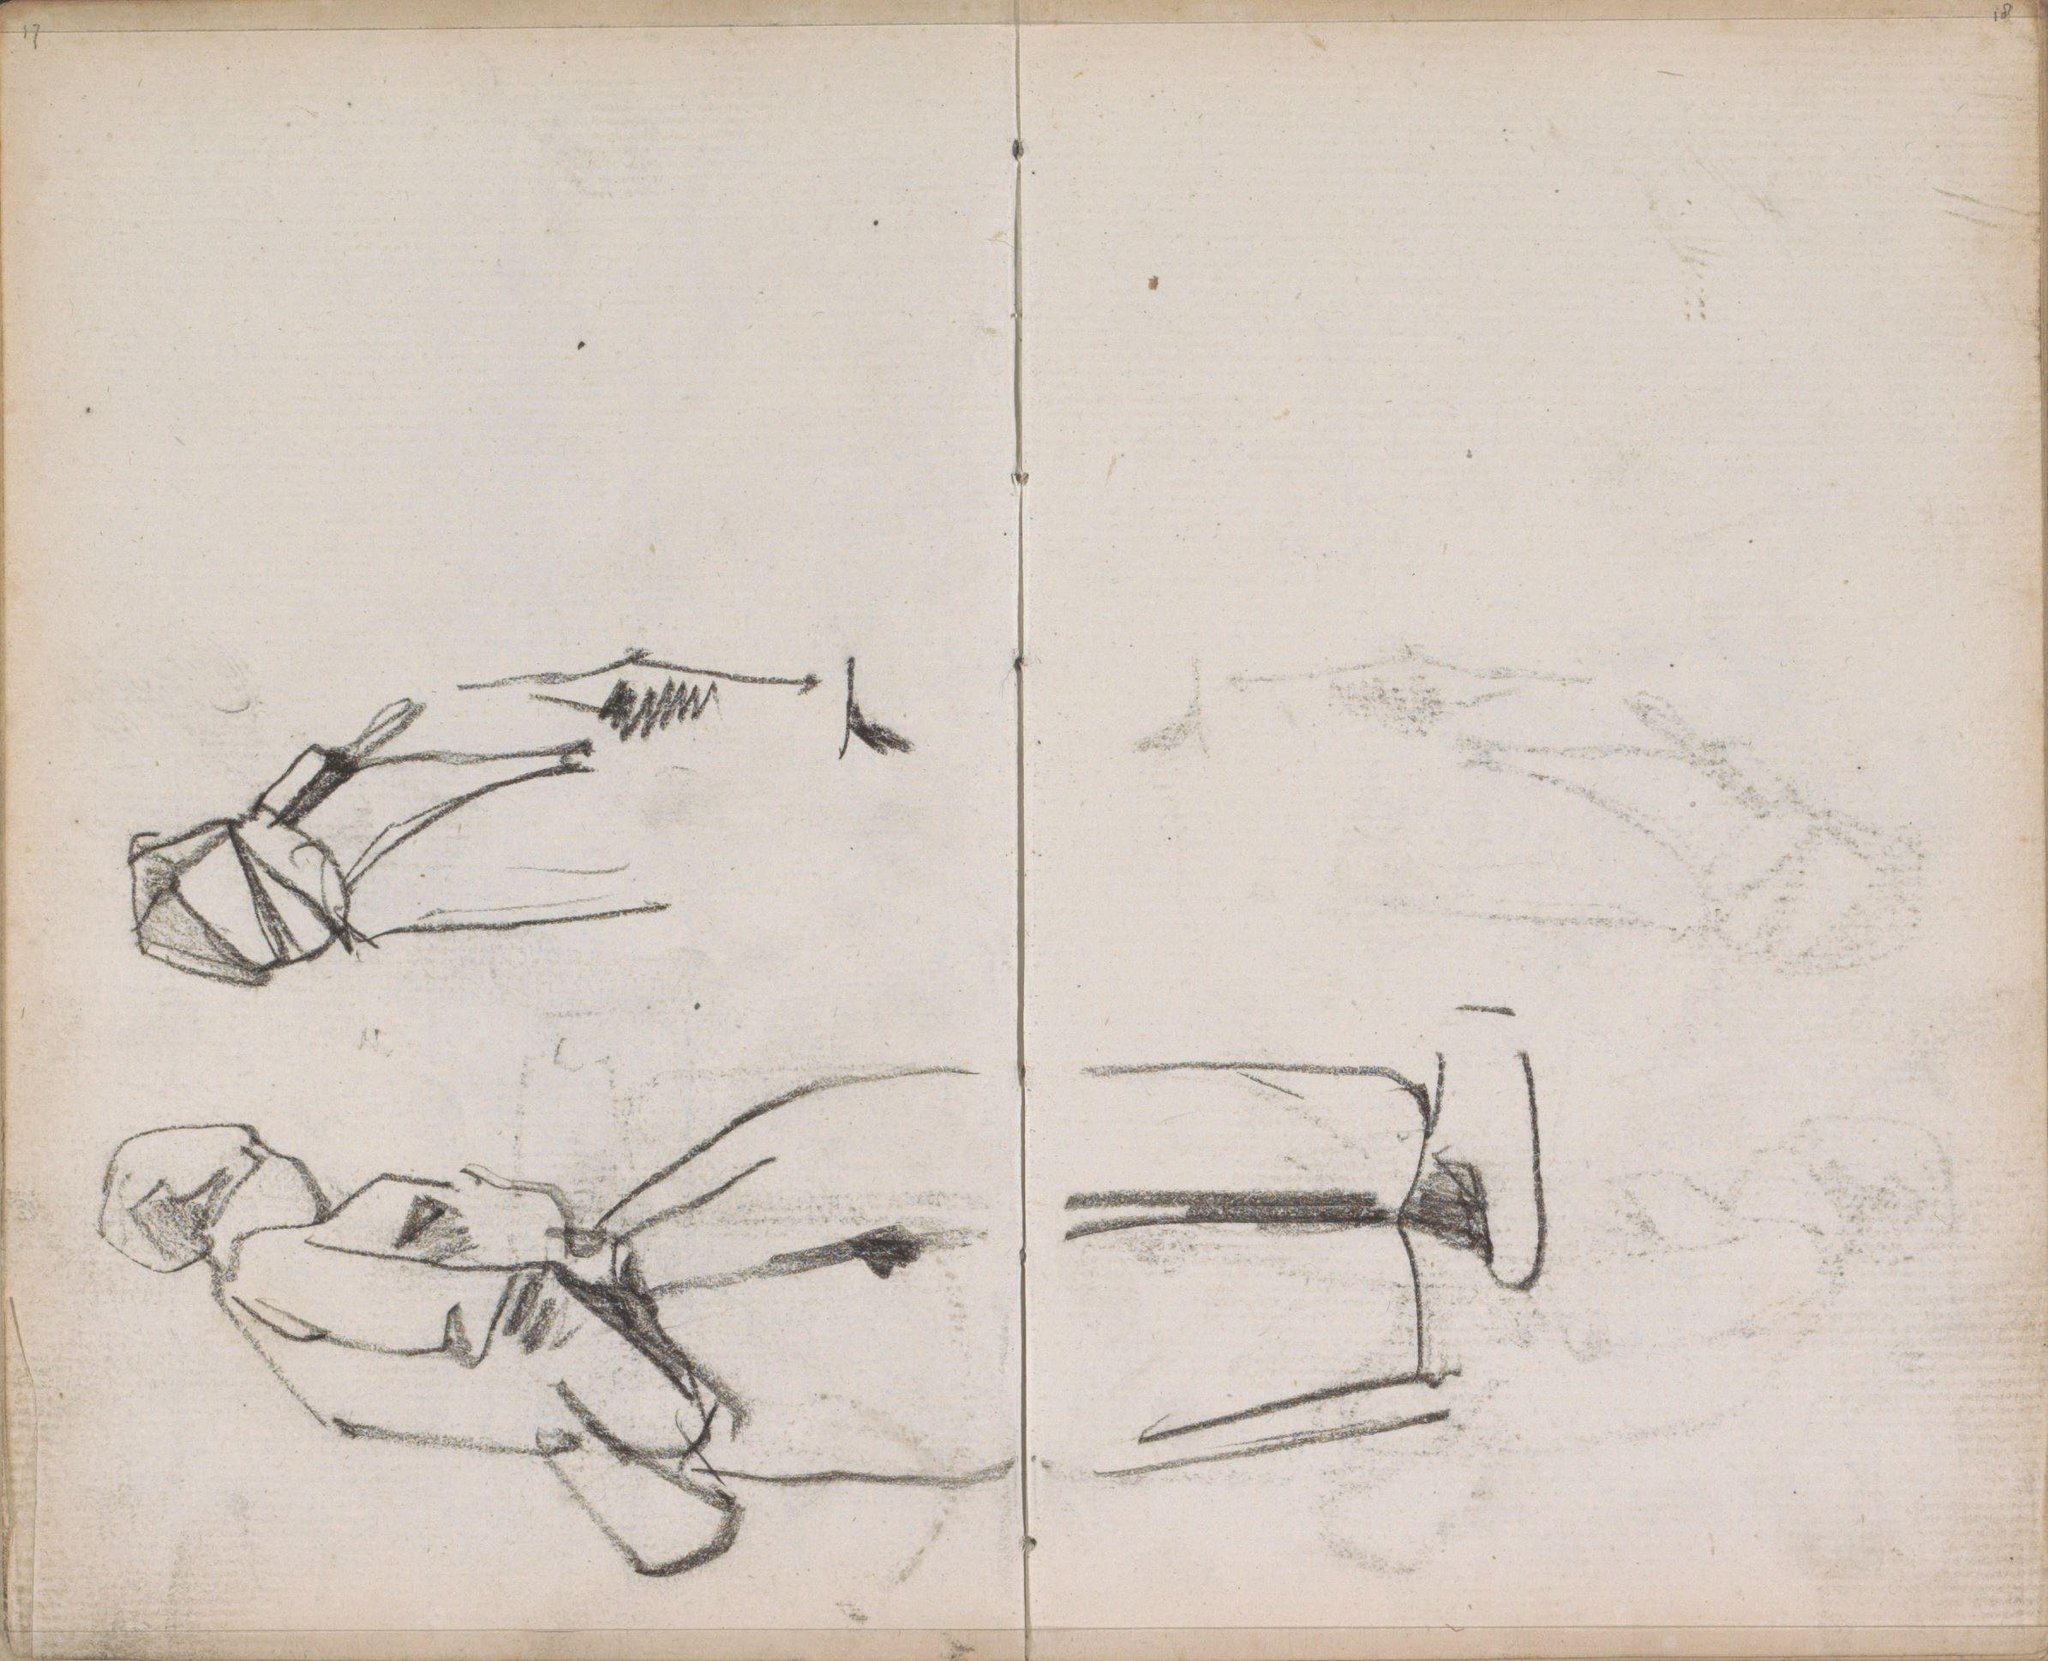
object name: sketchbook leaf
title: Twee figuren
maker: george hendrik breitner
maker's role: draughtsman, painter, print maker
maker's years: 1857-1923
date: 1884-1886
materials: chalk, paper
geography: drenthe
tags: farmers - aa - female farmer, farmer's wife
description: Links een boerin. Pagina 17 en pagina 18 uit een schetsboek met 67 bladen vervaardigd in Drenthe.